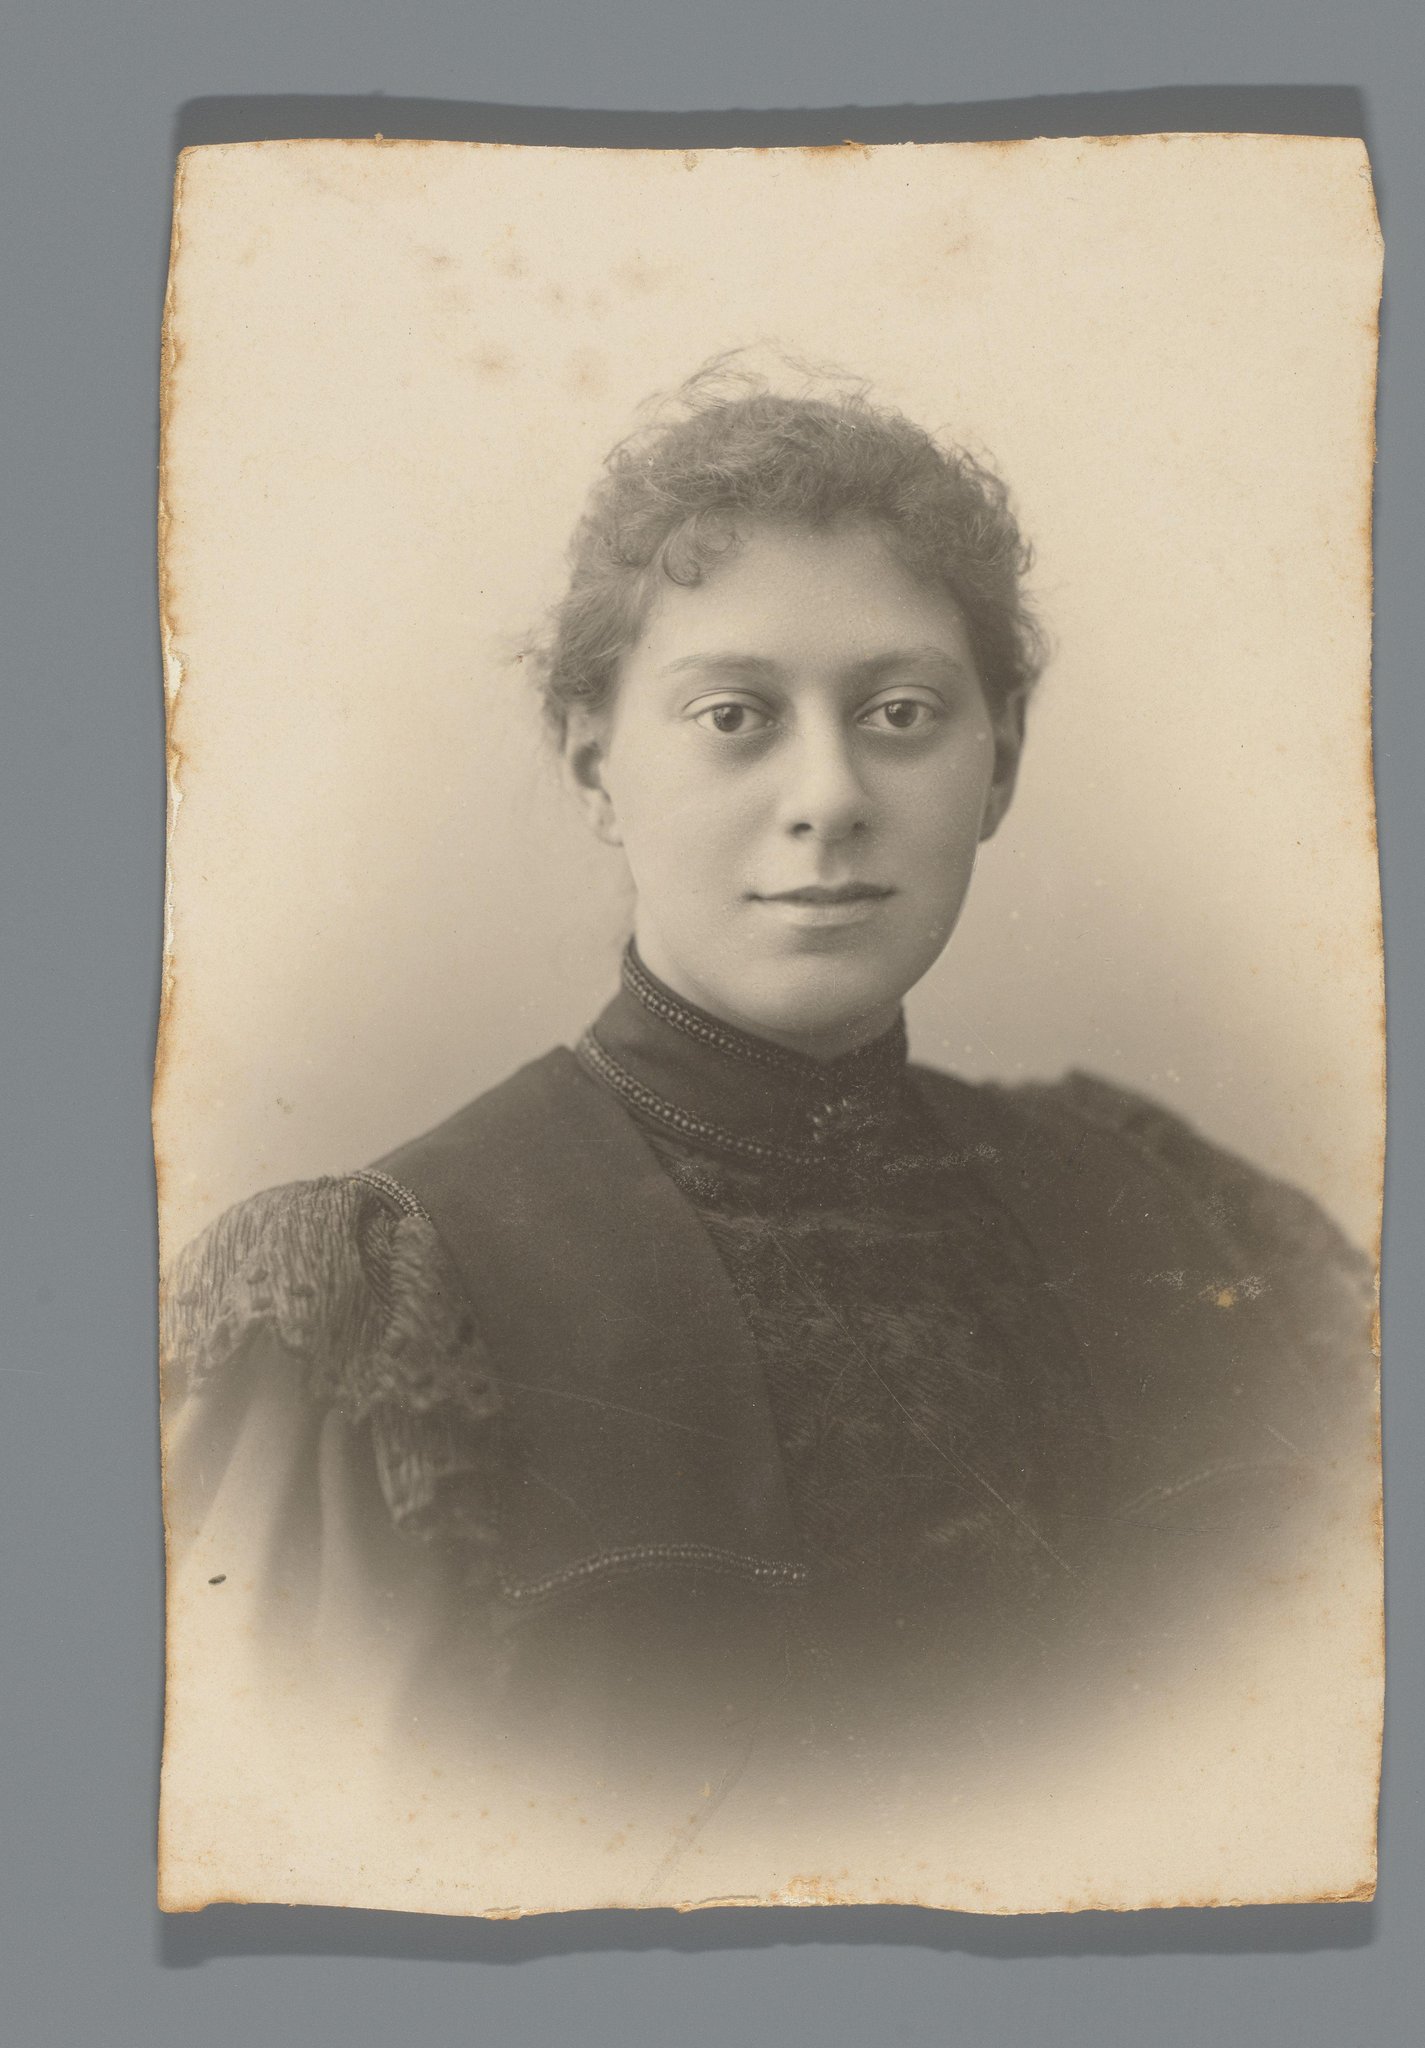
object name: cabinet photograph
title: Portret van Marie van der Mey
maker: albert greiner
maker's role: fotograaf, fotostudio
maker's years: 1833-1890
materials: cardboard, photographic support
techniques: gelatin silver print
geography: amsterdam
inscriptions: inscription: ‘Marie van der Mey’